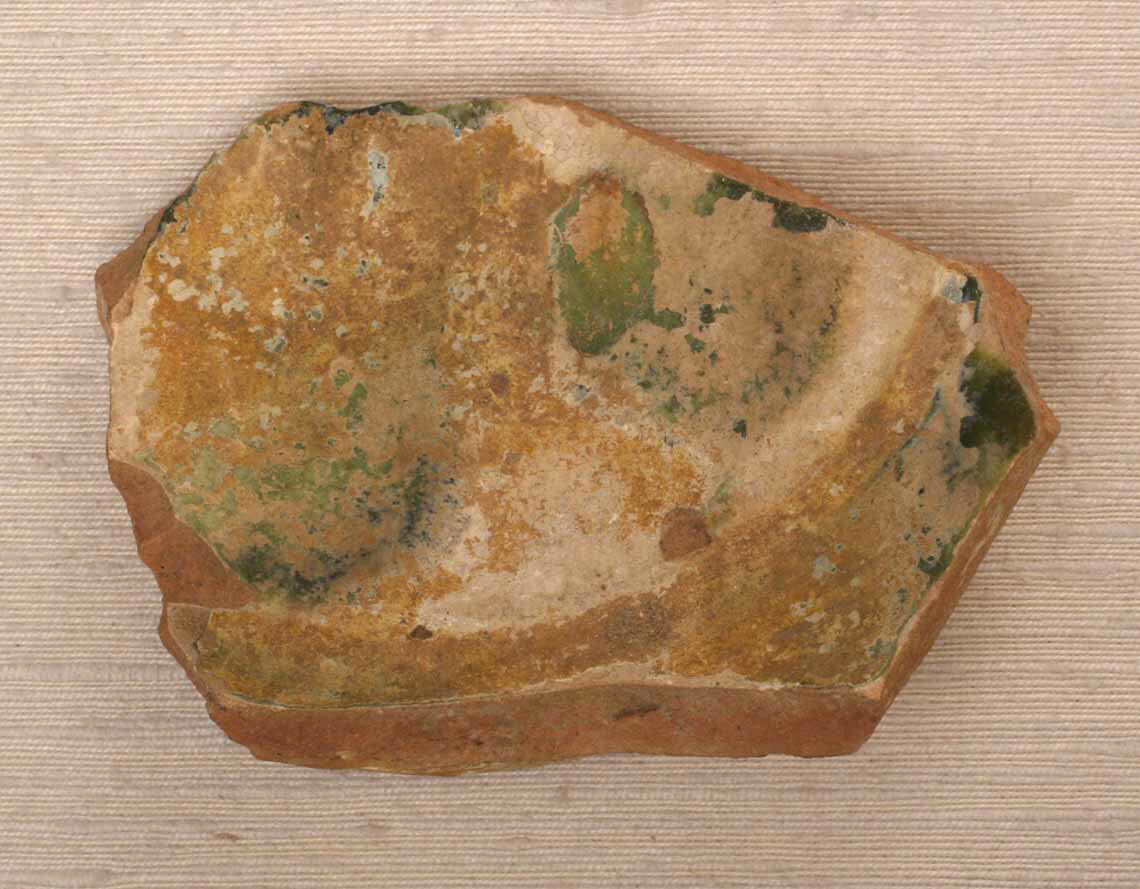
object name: fragment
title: Fragments of Splashed Ceramic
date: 801-900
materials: earthenware, glaze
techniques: painting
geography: iraq